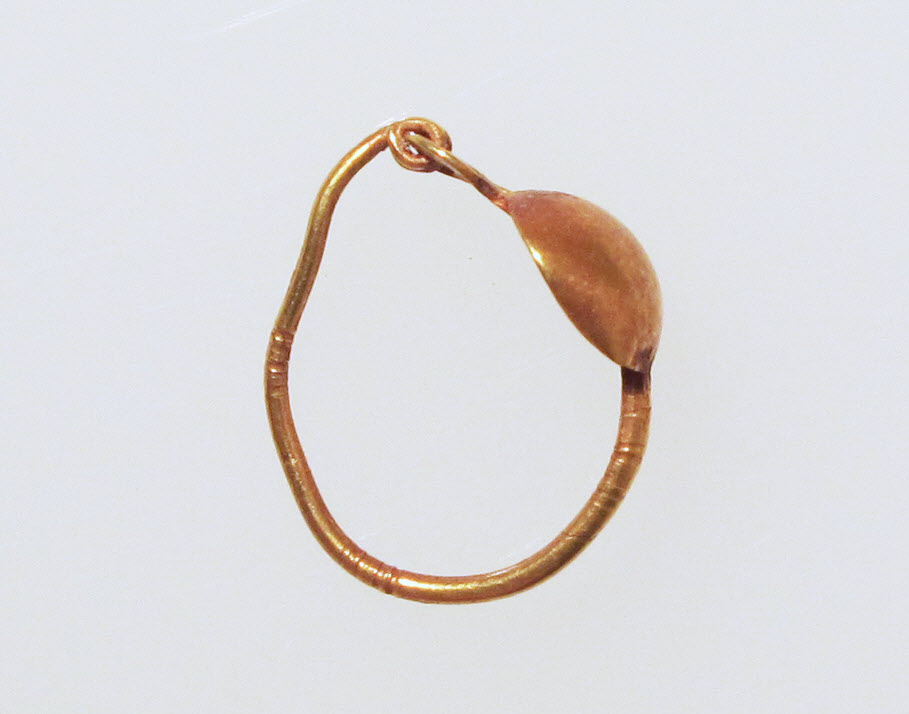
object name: earring with plain loop and disc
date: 7000 BCE-330 CE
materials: gold